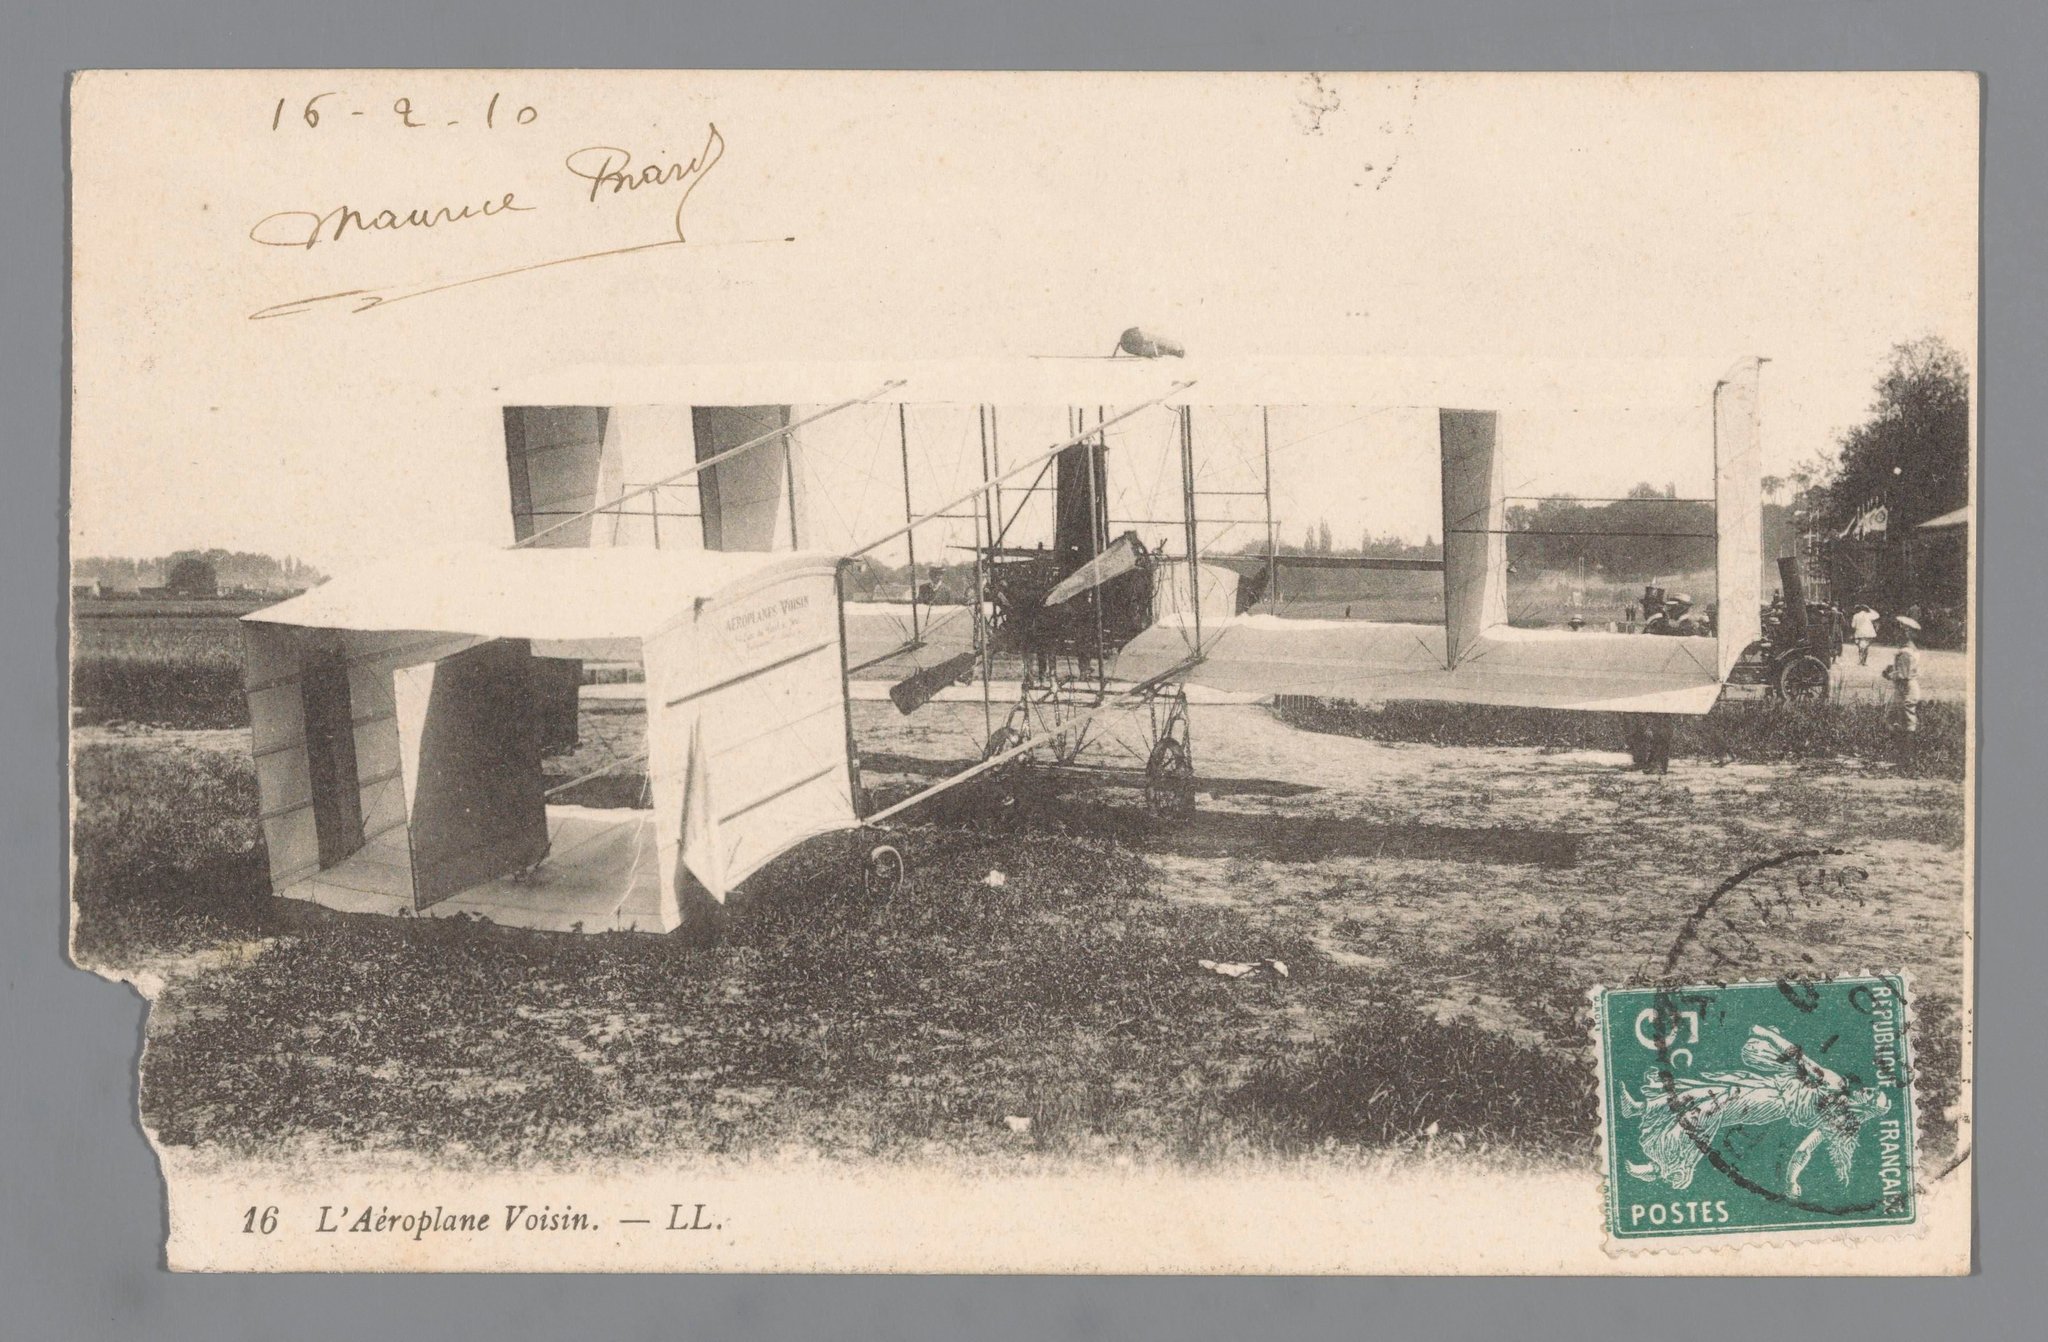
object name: ansichtkaart, prentbriefkaart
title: Vliegtuig van Voisin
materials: paper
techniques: photograph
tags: aircraft, aeroplane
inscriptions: number: ‘16’, inscription: ‘Maurice Biard (...) Delft Hollande’, inscription: ‘16-2-10 Maurice Biard’